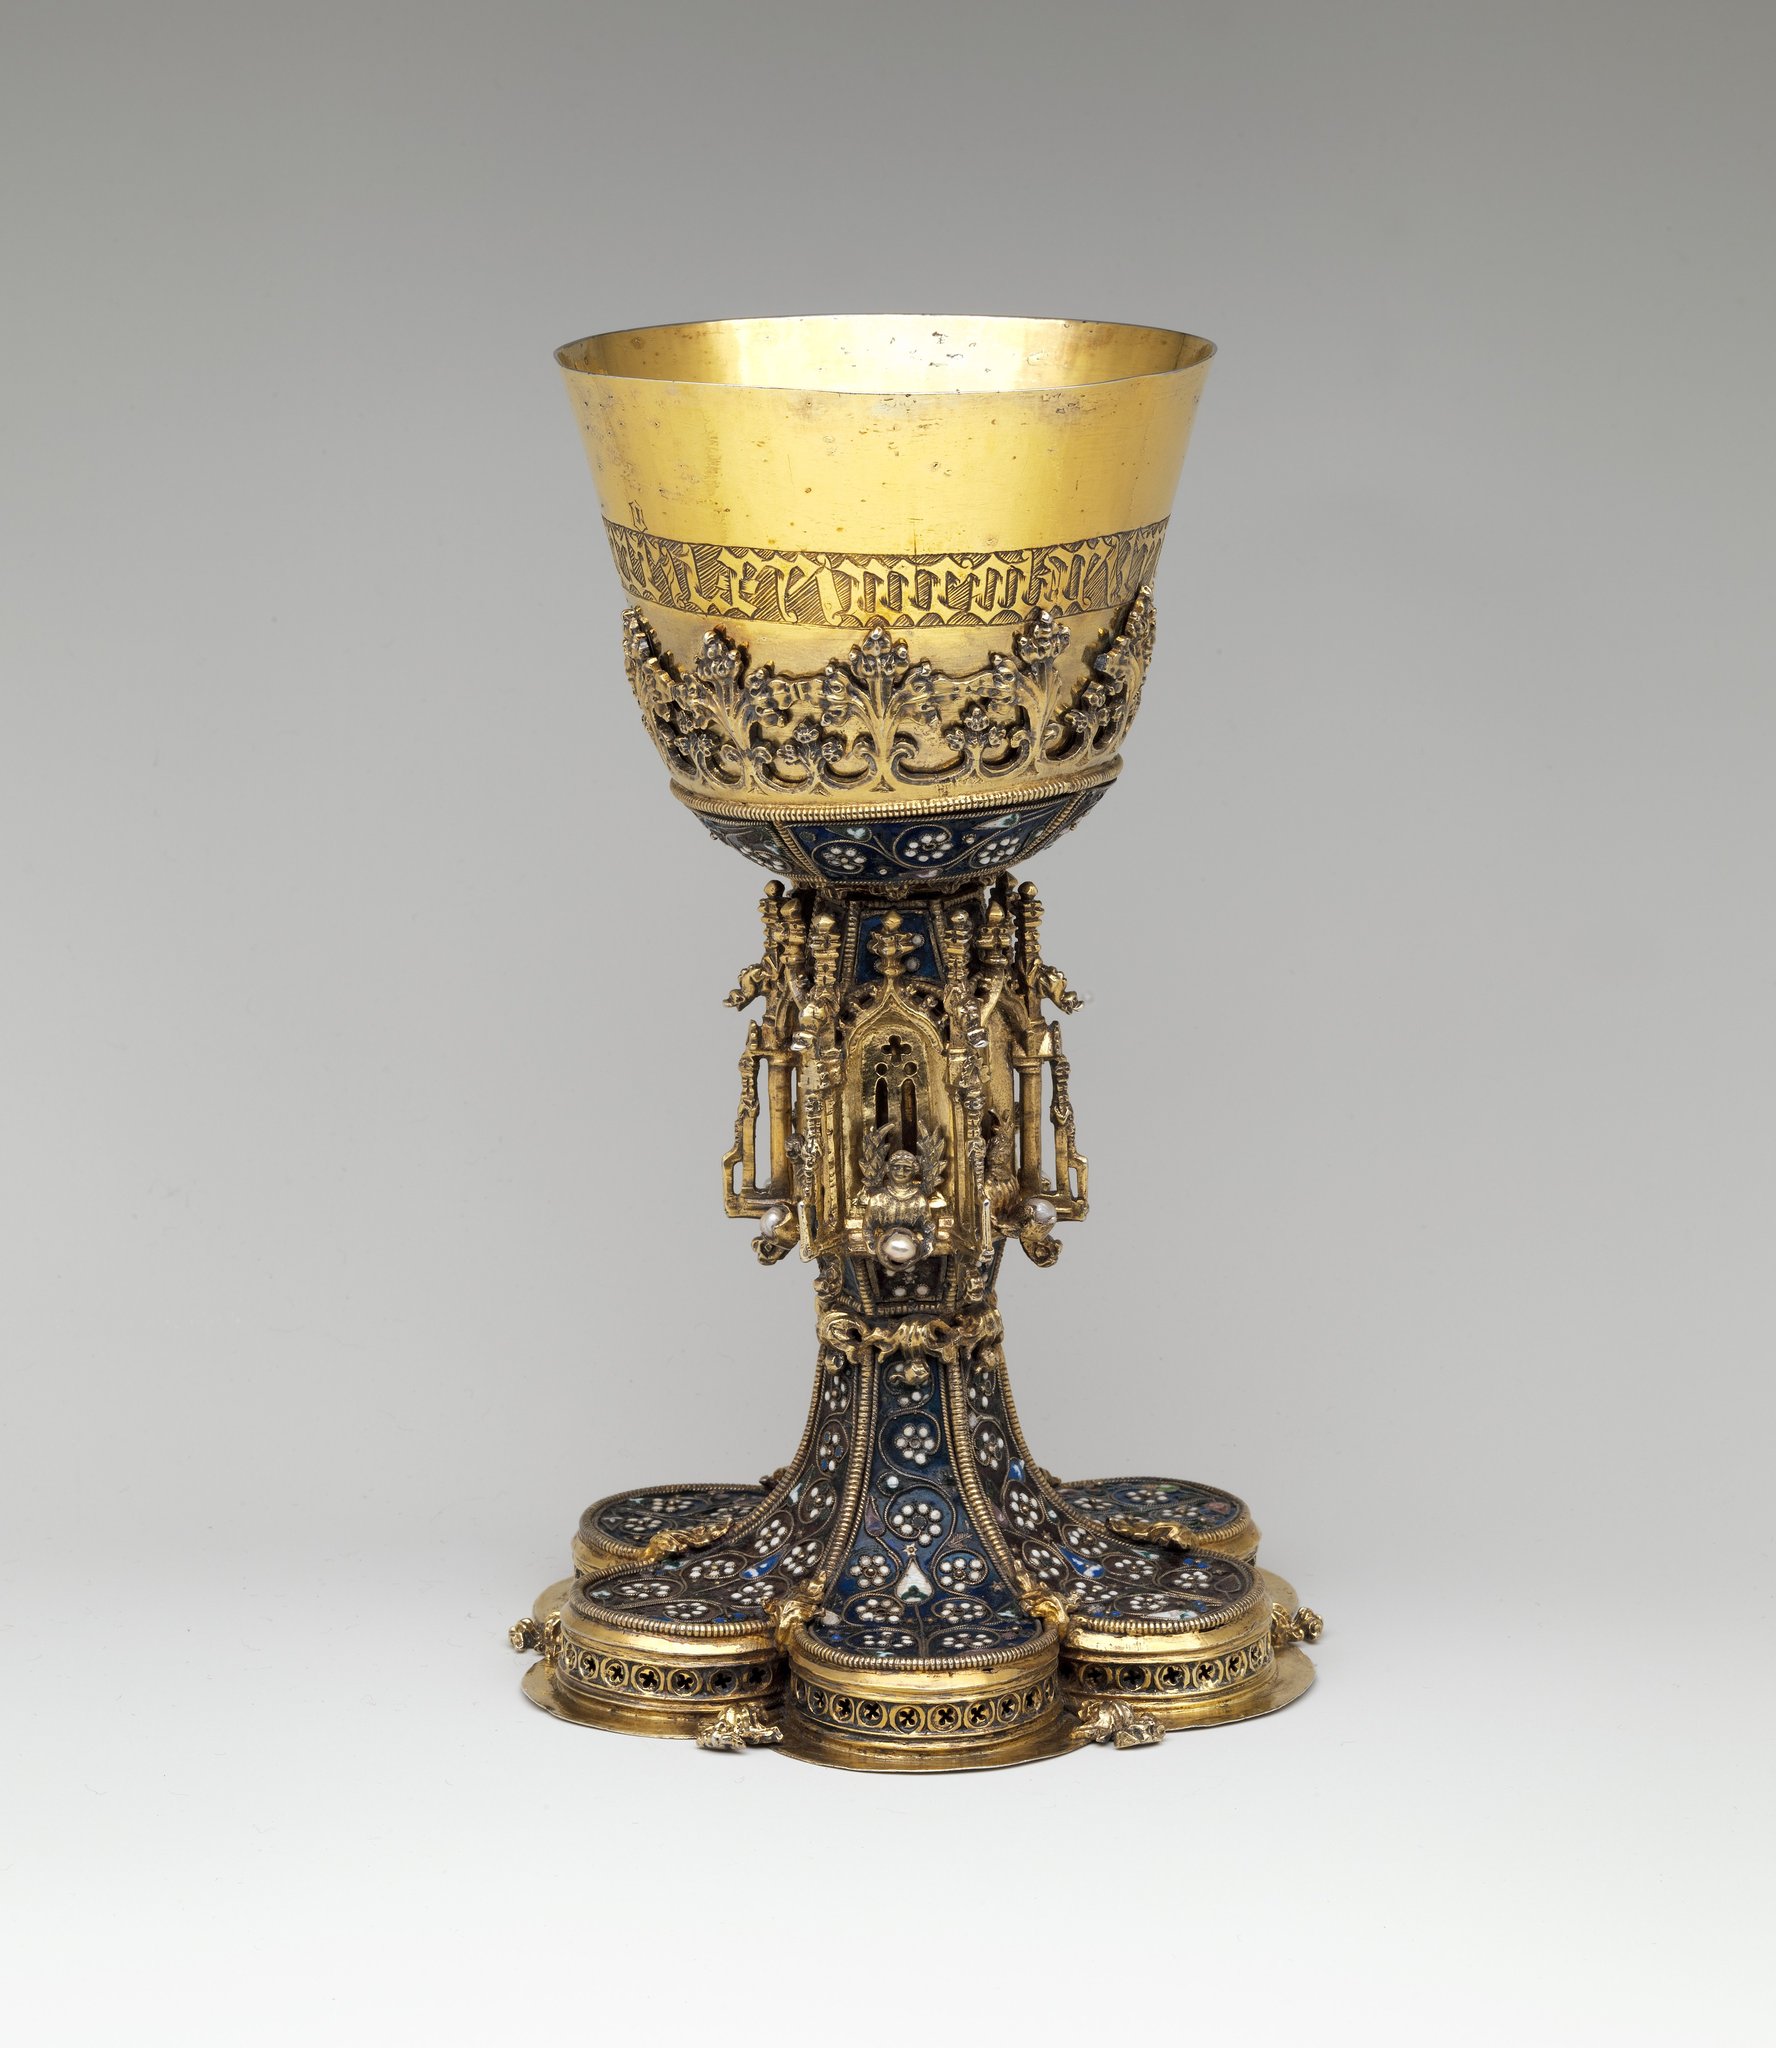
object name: chalice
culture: southeastern european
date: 1462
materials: enamel, gilt silver, pearl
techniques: filigree